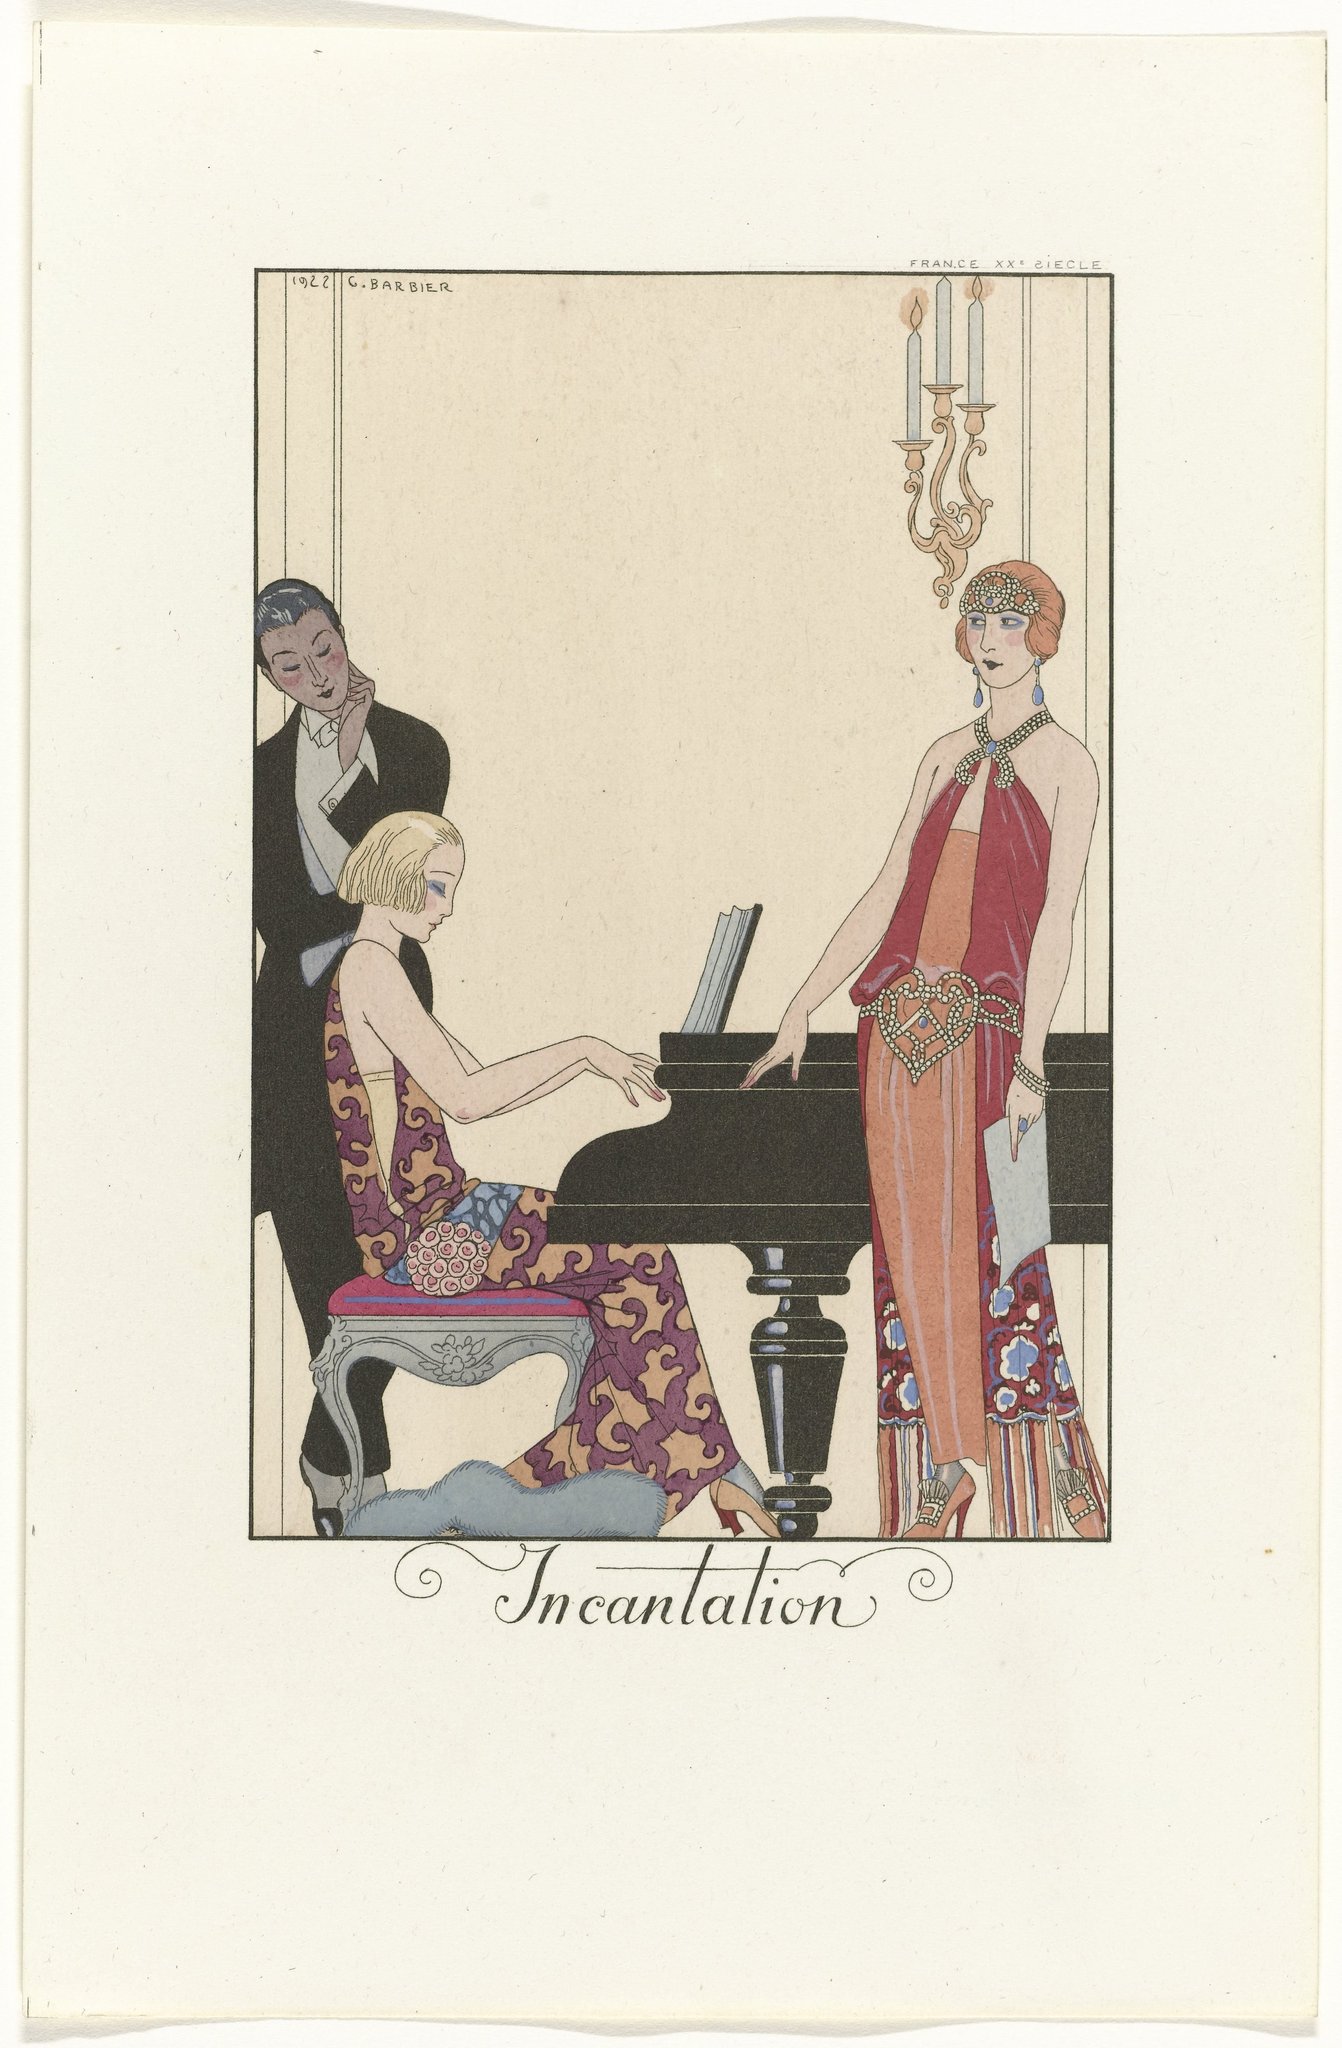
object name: fashion print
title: Joie de vivre: Falbalas et Fanfreluches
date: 1922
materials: paper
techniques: hand coloring, lithograph, pochoir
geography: paris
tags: one person playing keyboard instrument, diadem, tiara (+ women's clothes), dress, gown: evening dress (+ women's clothes), grand piano, fashion plates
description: Luxuriously produced fashion series by artists immerse the reader in a world of exotic colours and joie de vivre. George Barbier writes in the introduction of Le Bonheur du Jour that everything in his album delights the eye: extravagant clothing, feather fans, amorous entangle-ments, and pleasant diversion.